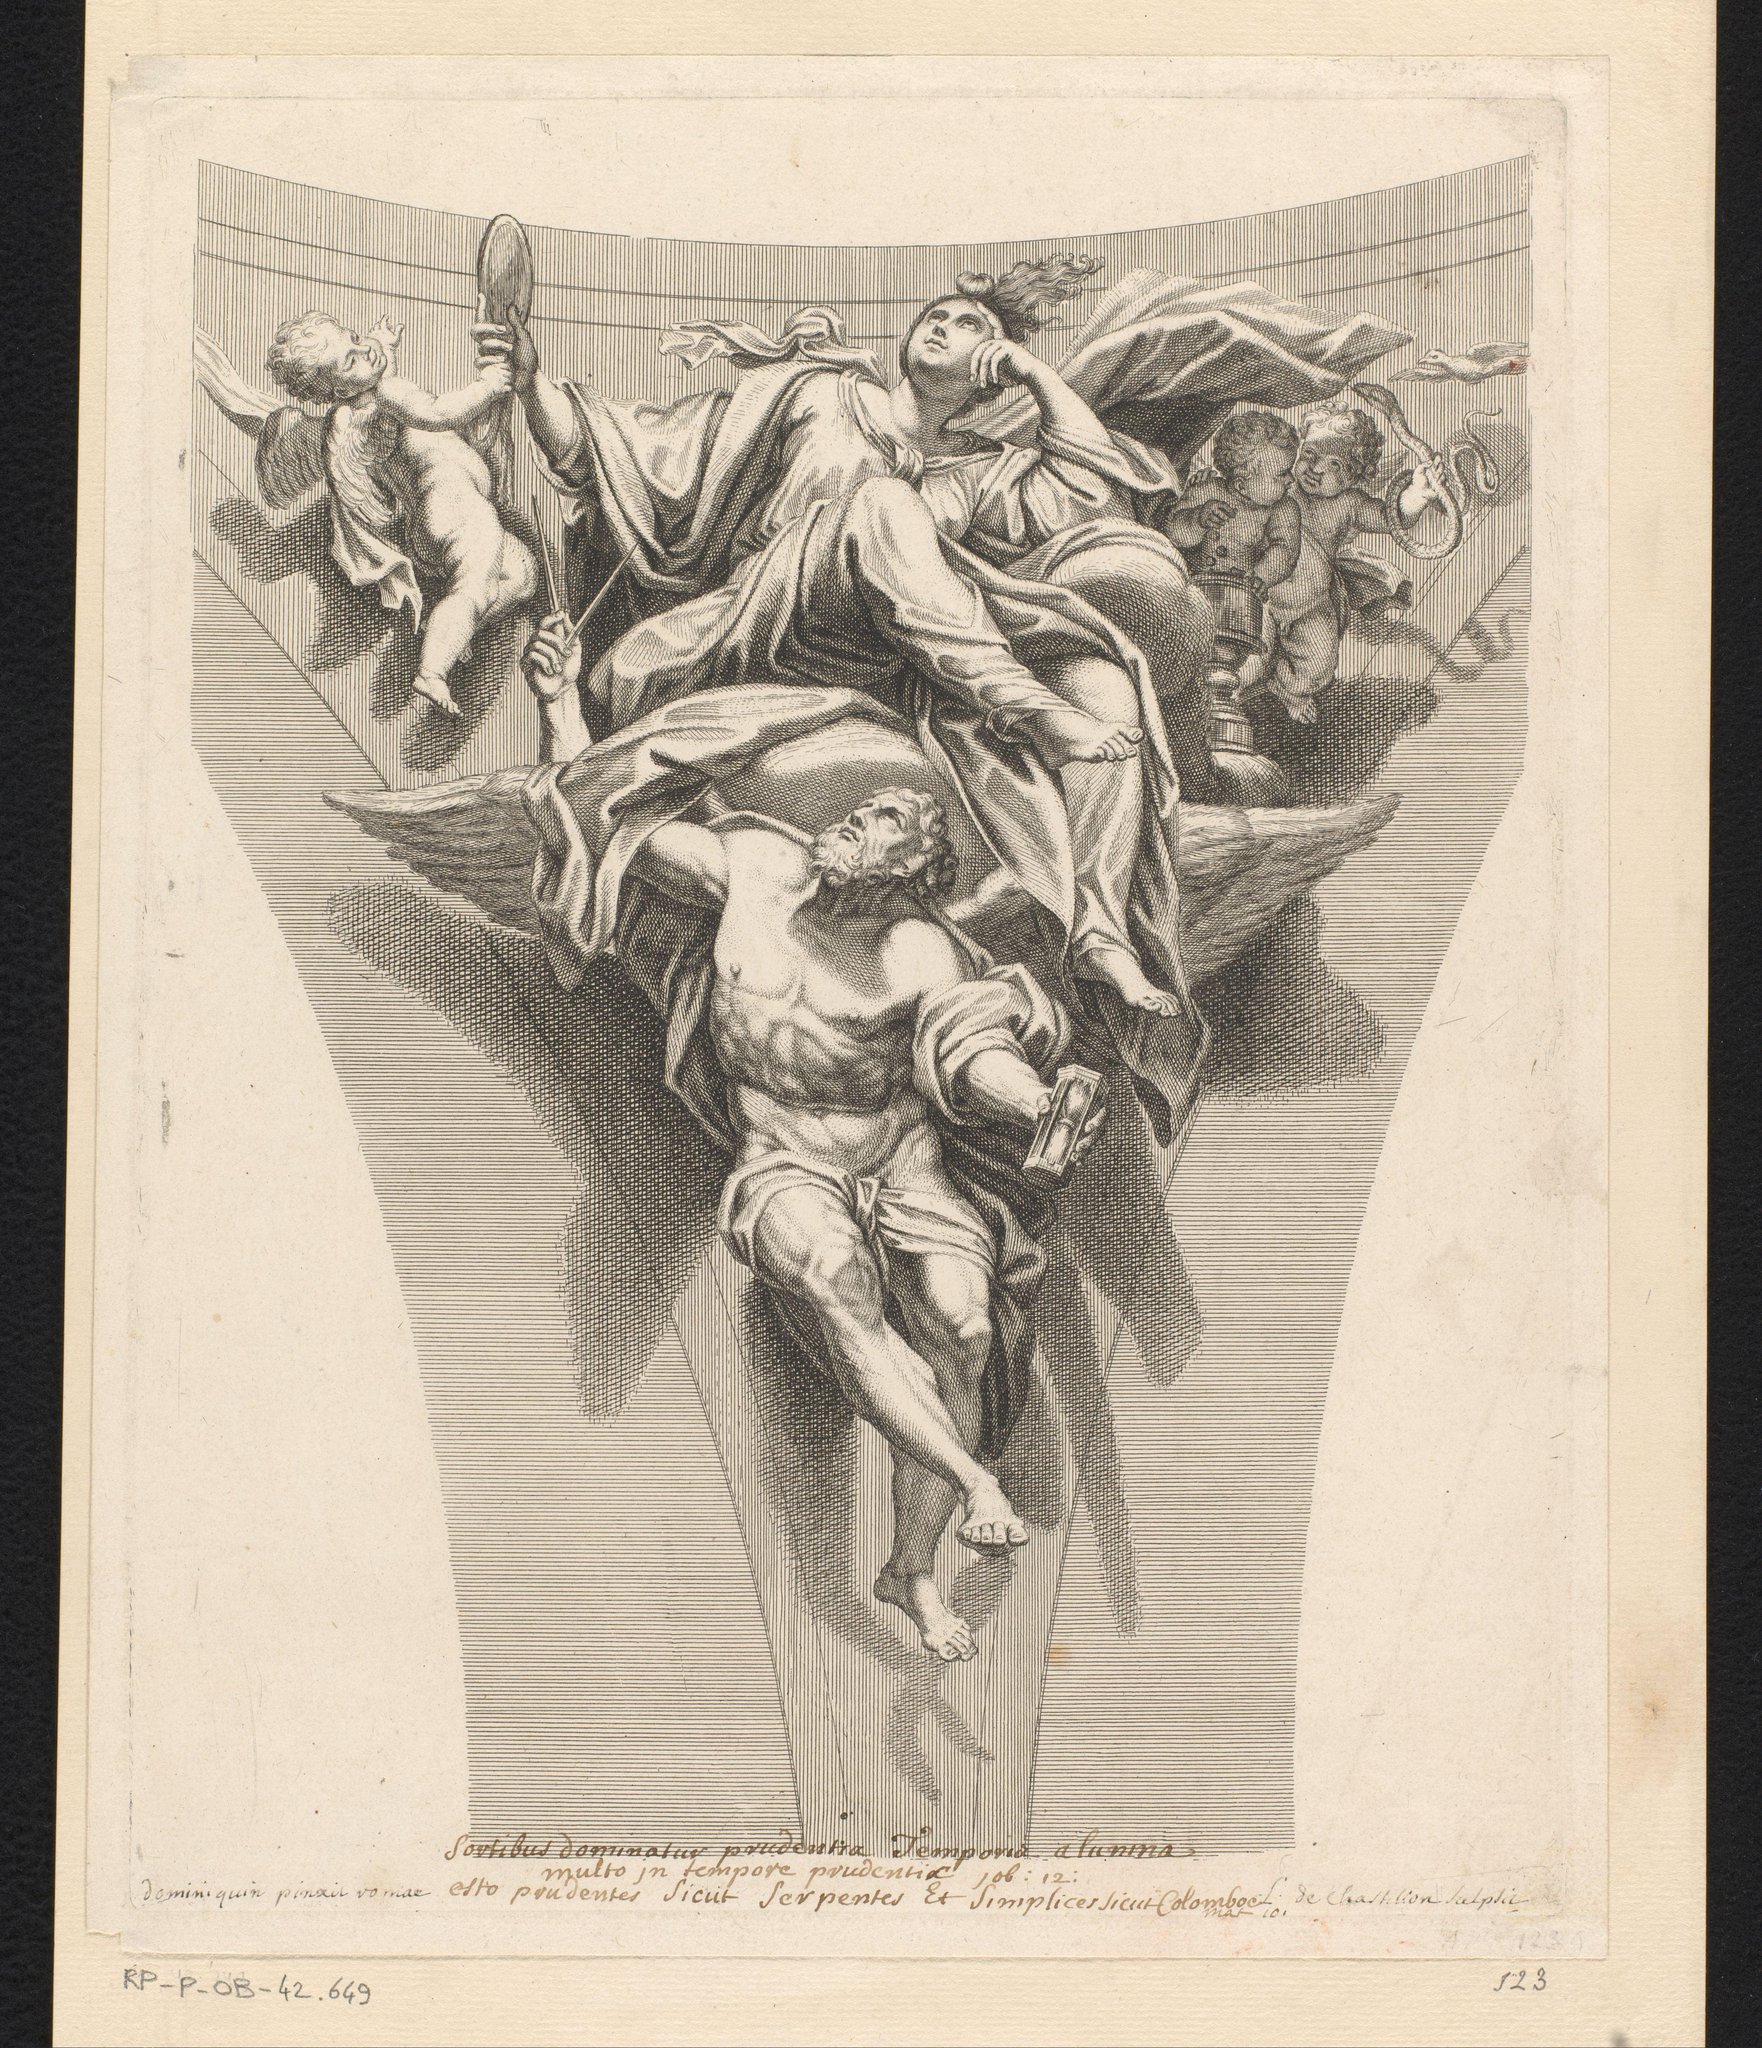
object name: print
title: Personificaties van de kardinale deugden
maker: louis de châtillon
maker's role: print maker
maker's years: 1639-1734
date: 1649-1734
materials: paper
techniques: etching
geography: rome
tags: prudence, 'prudentia'; 'prudenza' (ripa) ~ one of the four cardinal virtues, architectural detail, father time, man with wings and scythe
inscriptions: collector's mark: Lugt 240, inscription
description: Maakt deel uit van een vierdelige serie met personificaties van de kardinale deugden naar fresco's door Domenichino in de San Carlo ai Catinari te Rome.